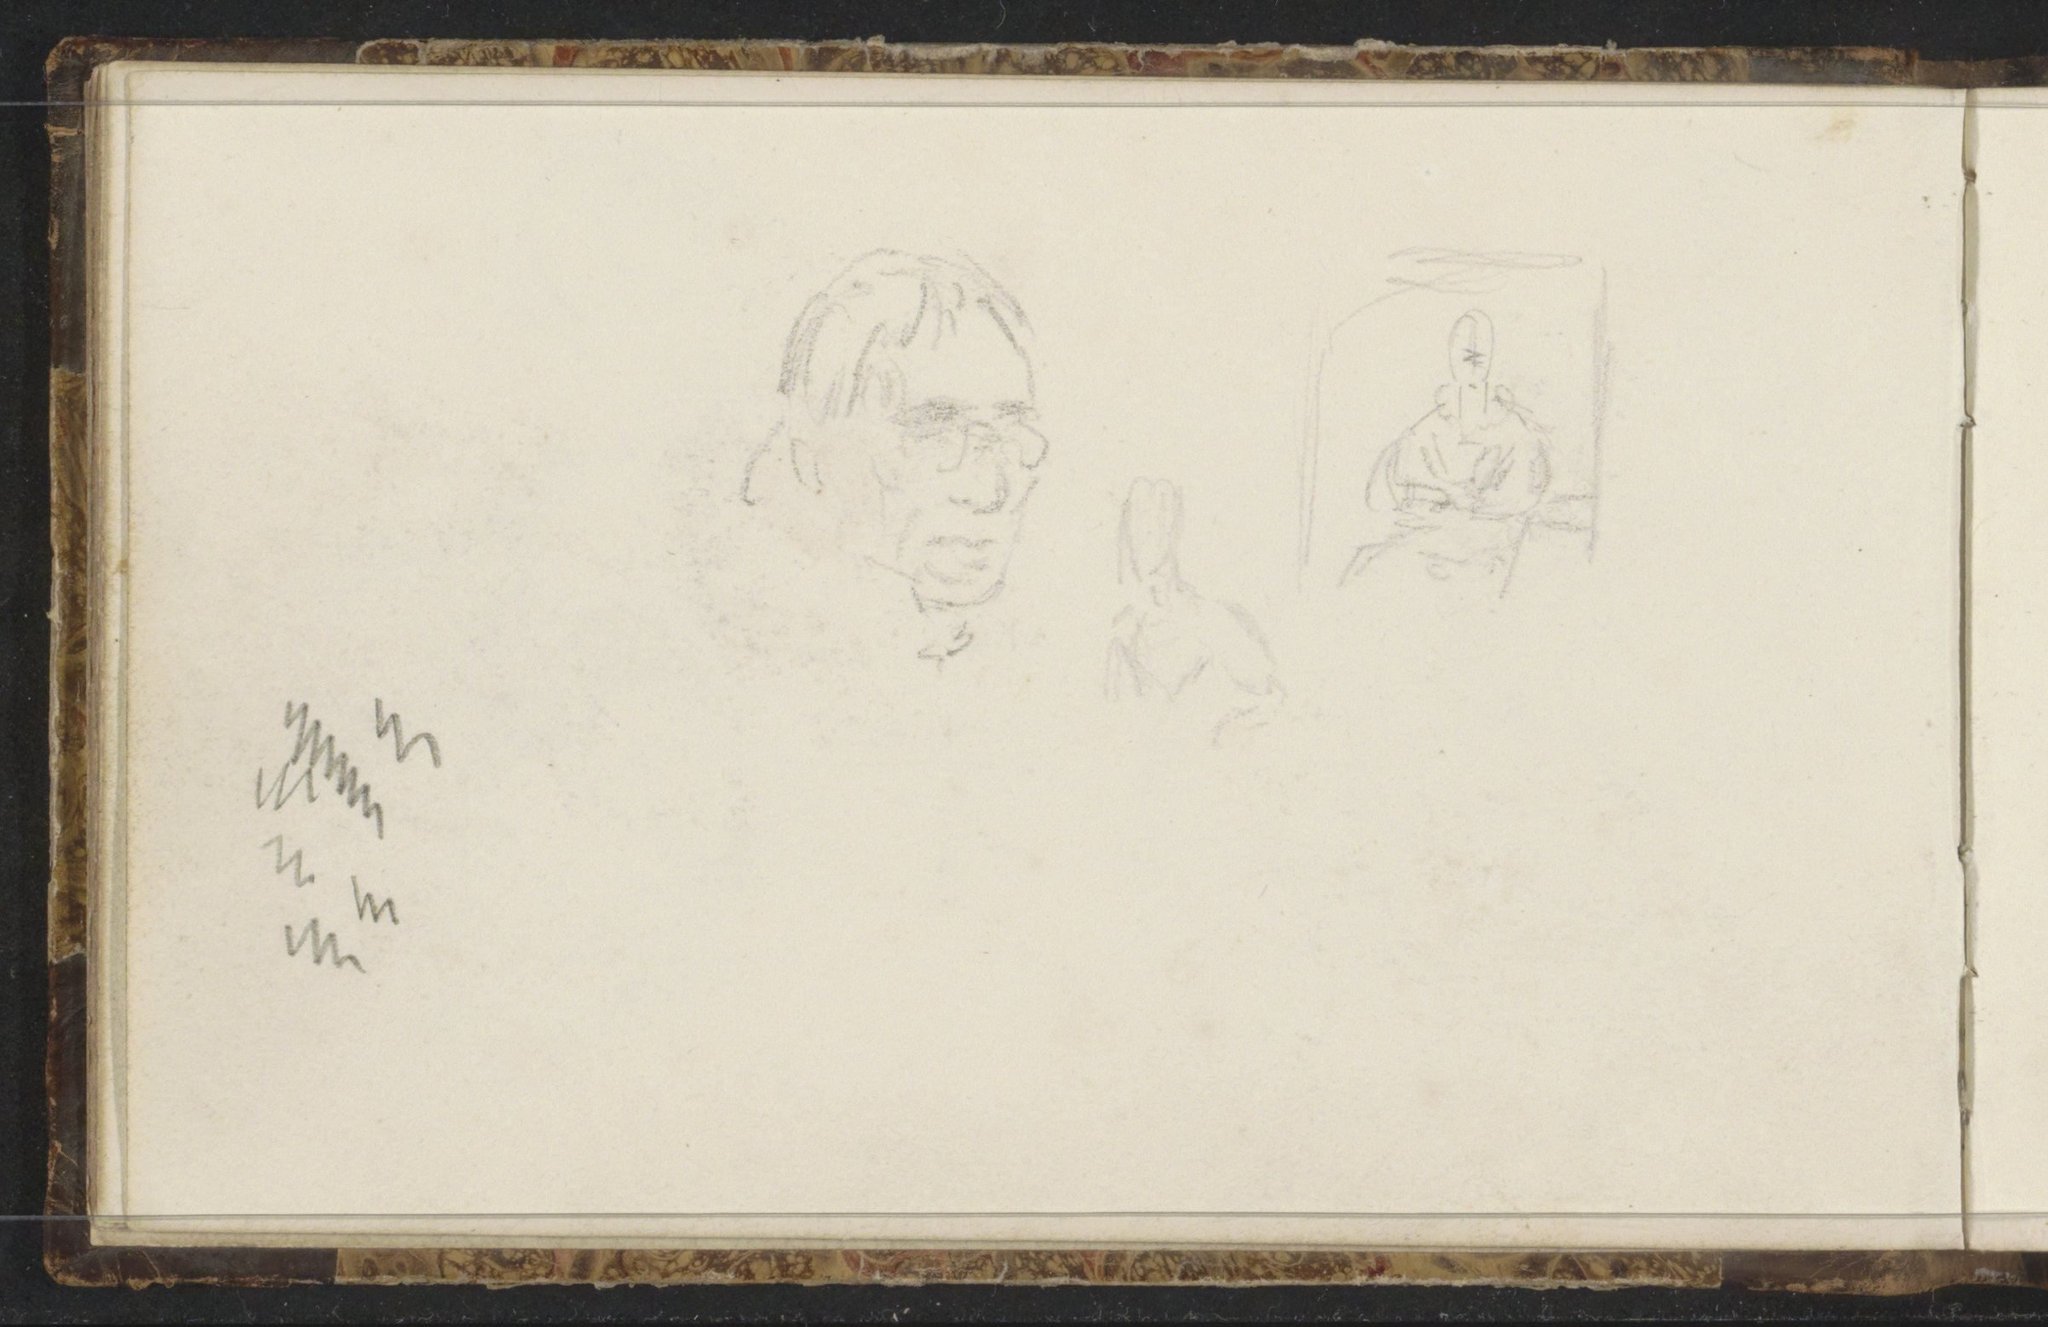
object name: sketchbook leaf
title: Kop van een man met bril en figuurstudies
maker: willem hendrik schmidt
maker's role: draughtsman, painter, print maker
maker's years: 1809-1849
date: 1819-1849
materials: paper, pencil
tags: eyeglasses, spectacles, head (human)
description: Blad 8 verso uit een schetsboek met 60 bladen.